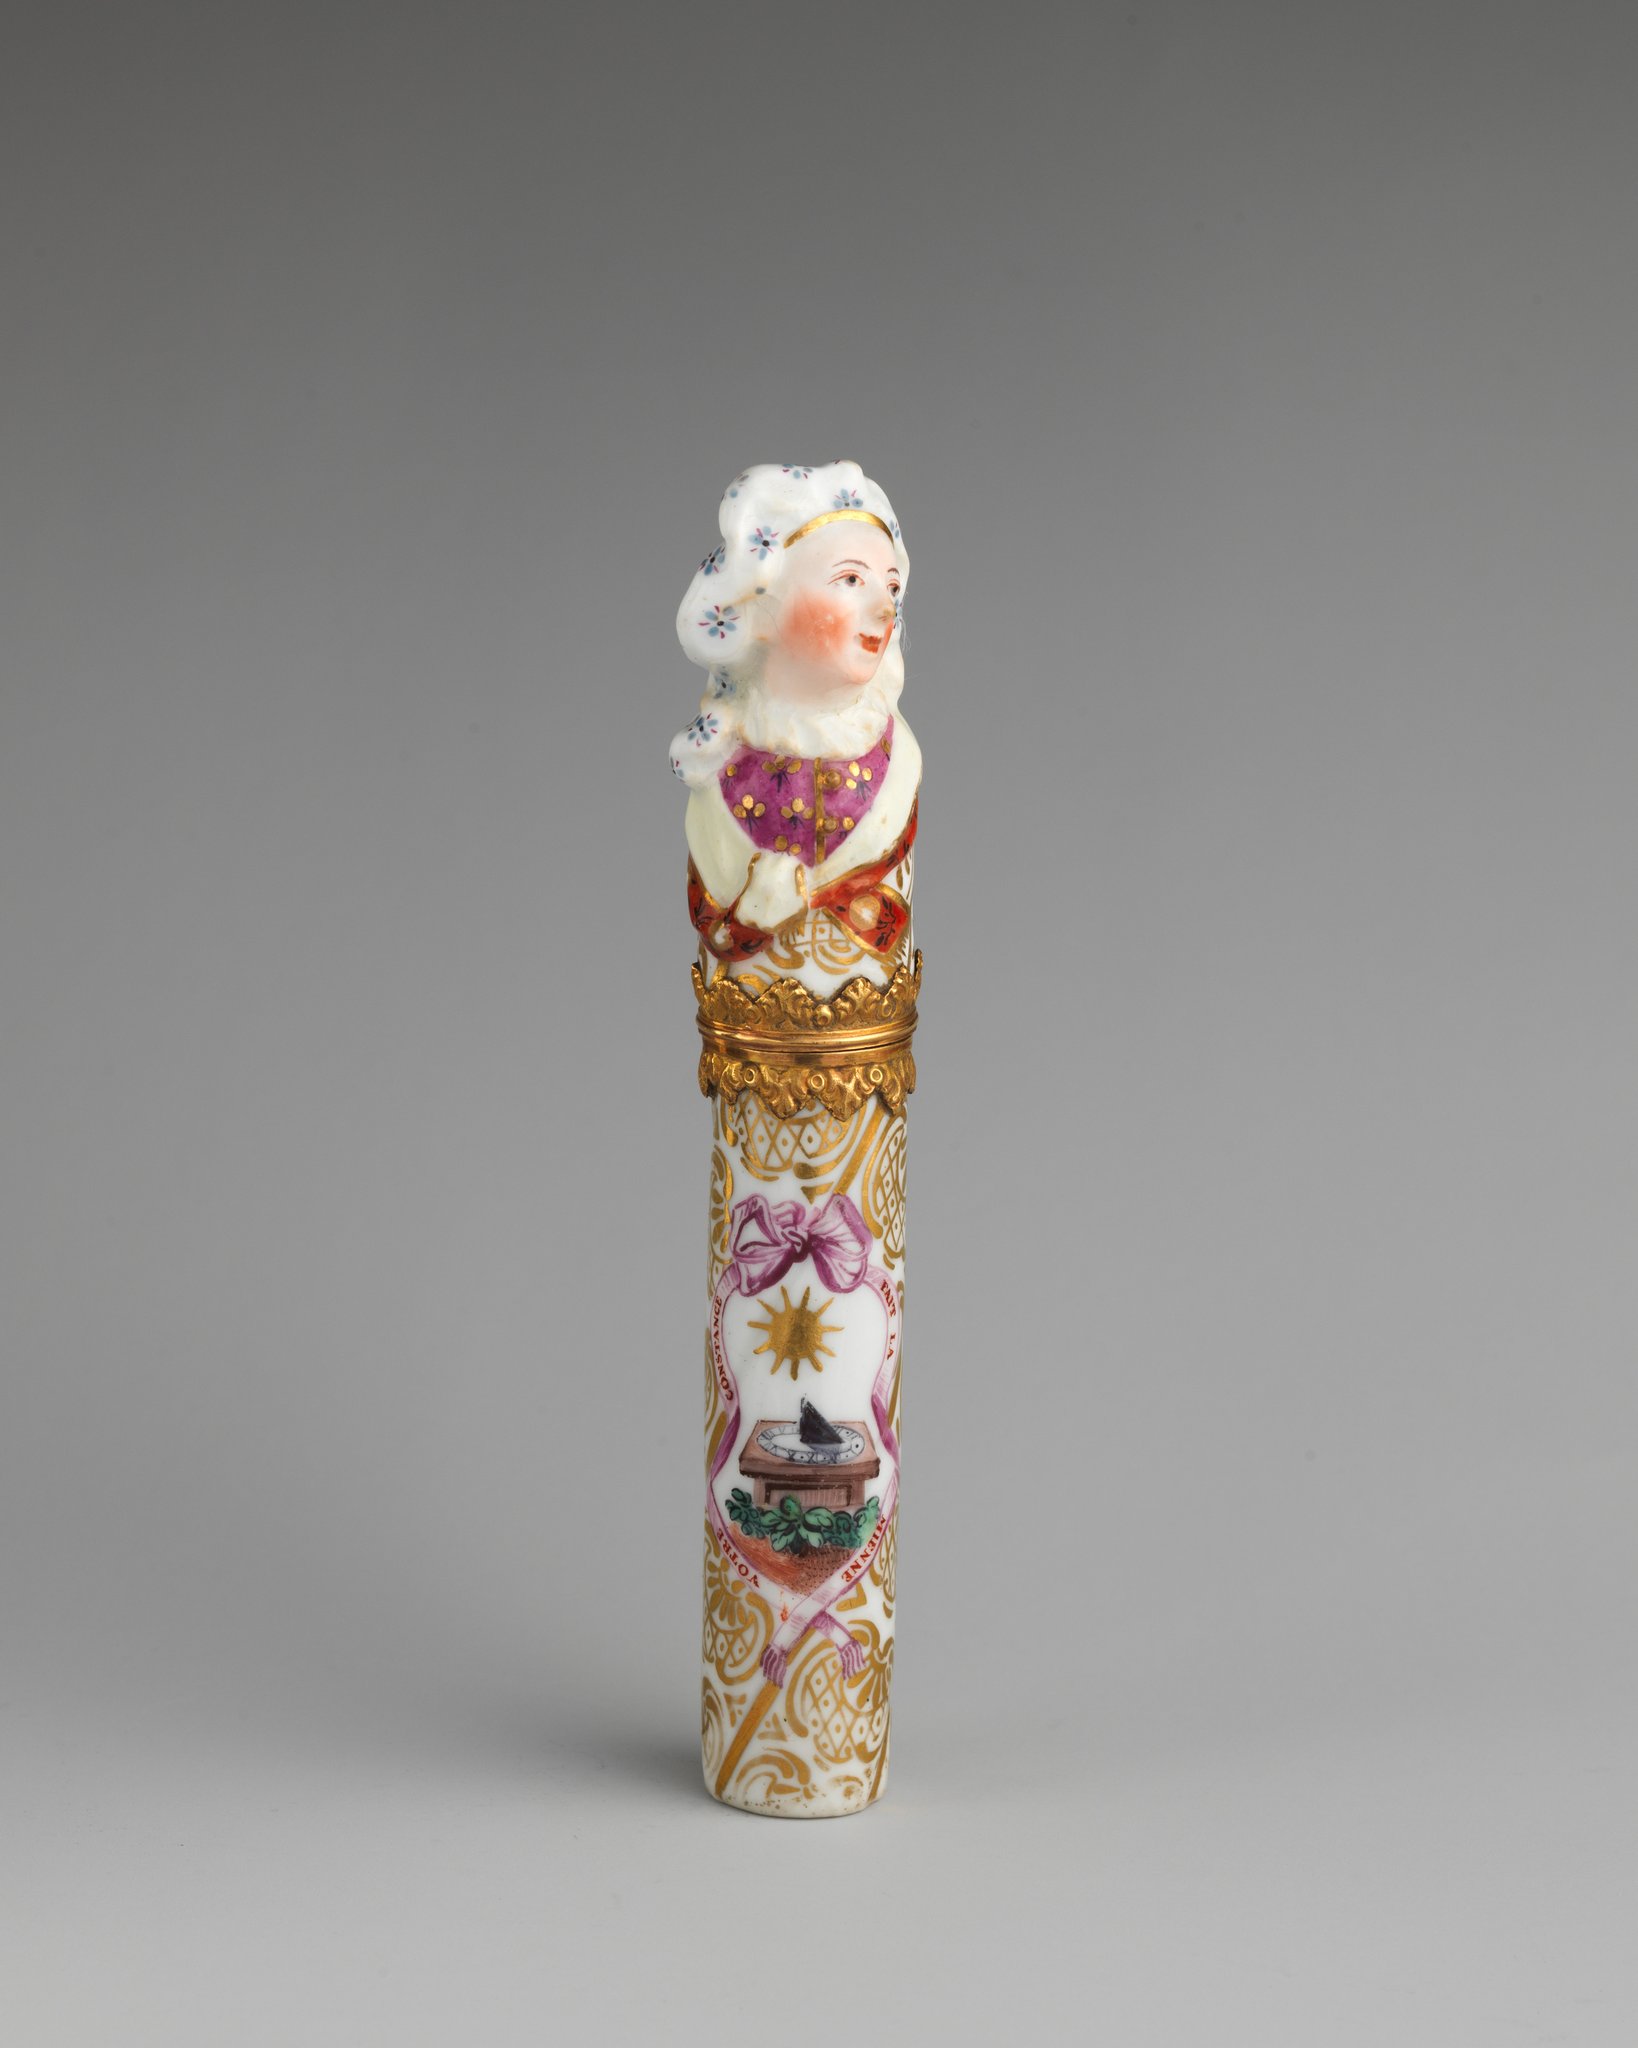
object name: toy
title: Male bust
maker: chelsea porcelain manufactory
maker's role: factory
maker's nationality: british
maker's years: 1744-1784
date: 1765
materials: soft paste porcelain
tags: men,sundials